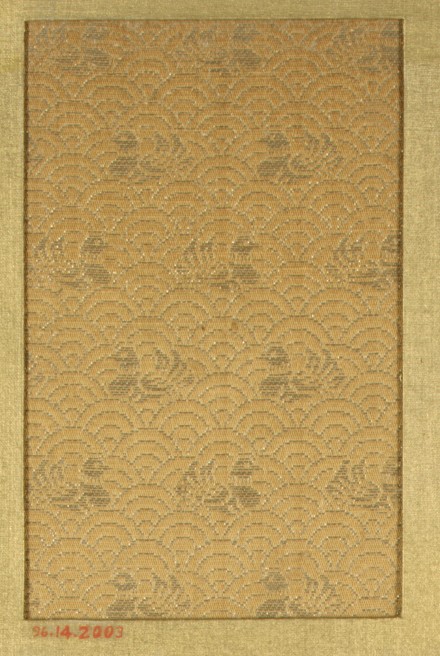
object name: piece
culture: japanese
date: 1701-1900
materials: silk